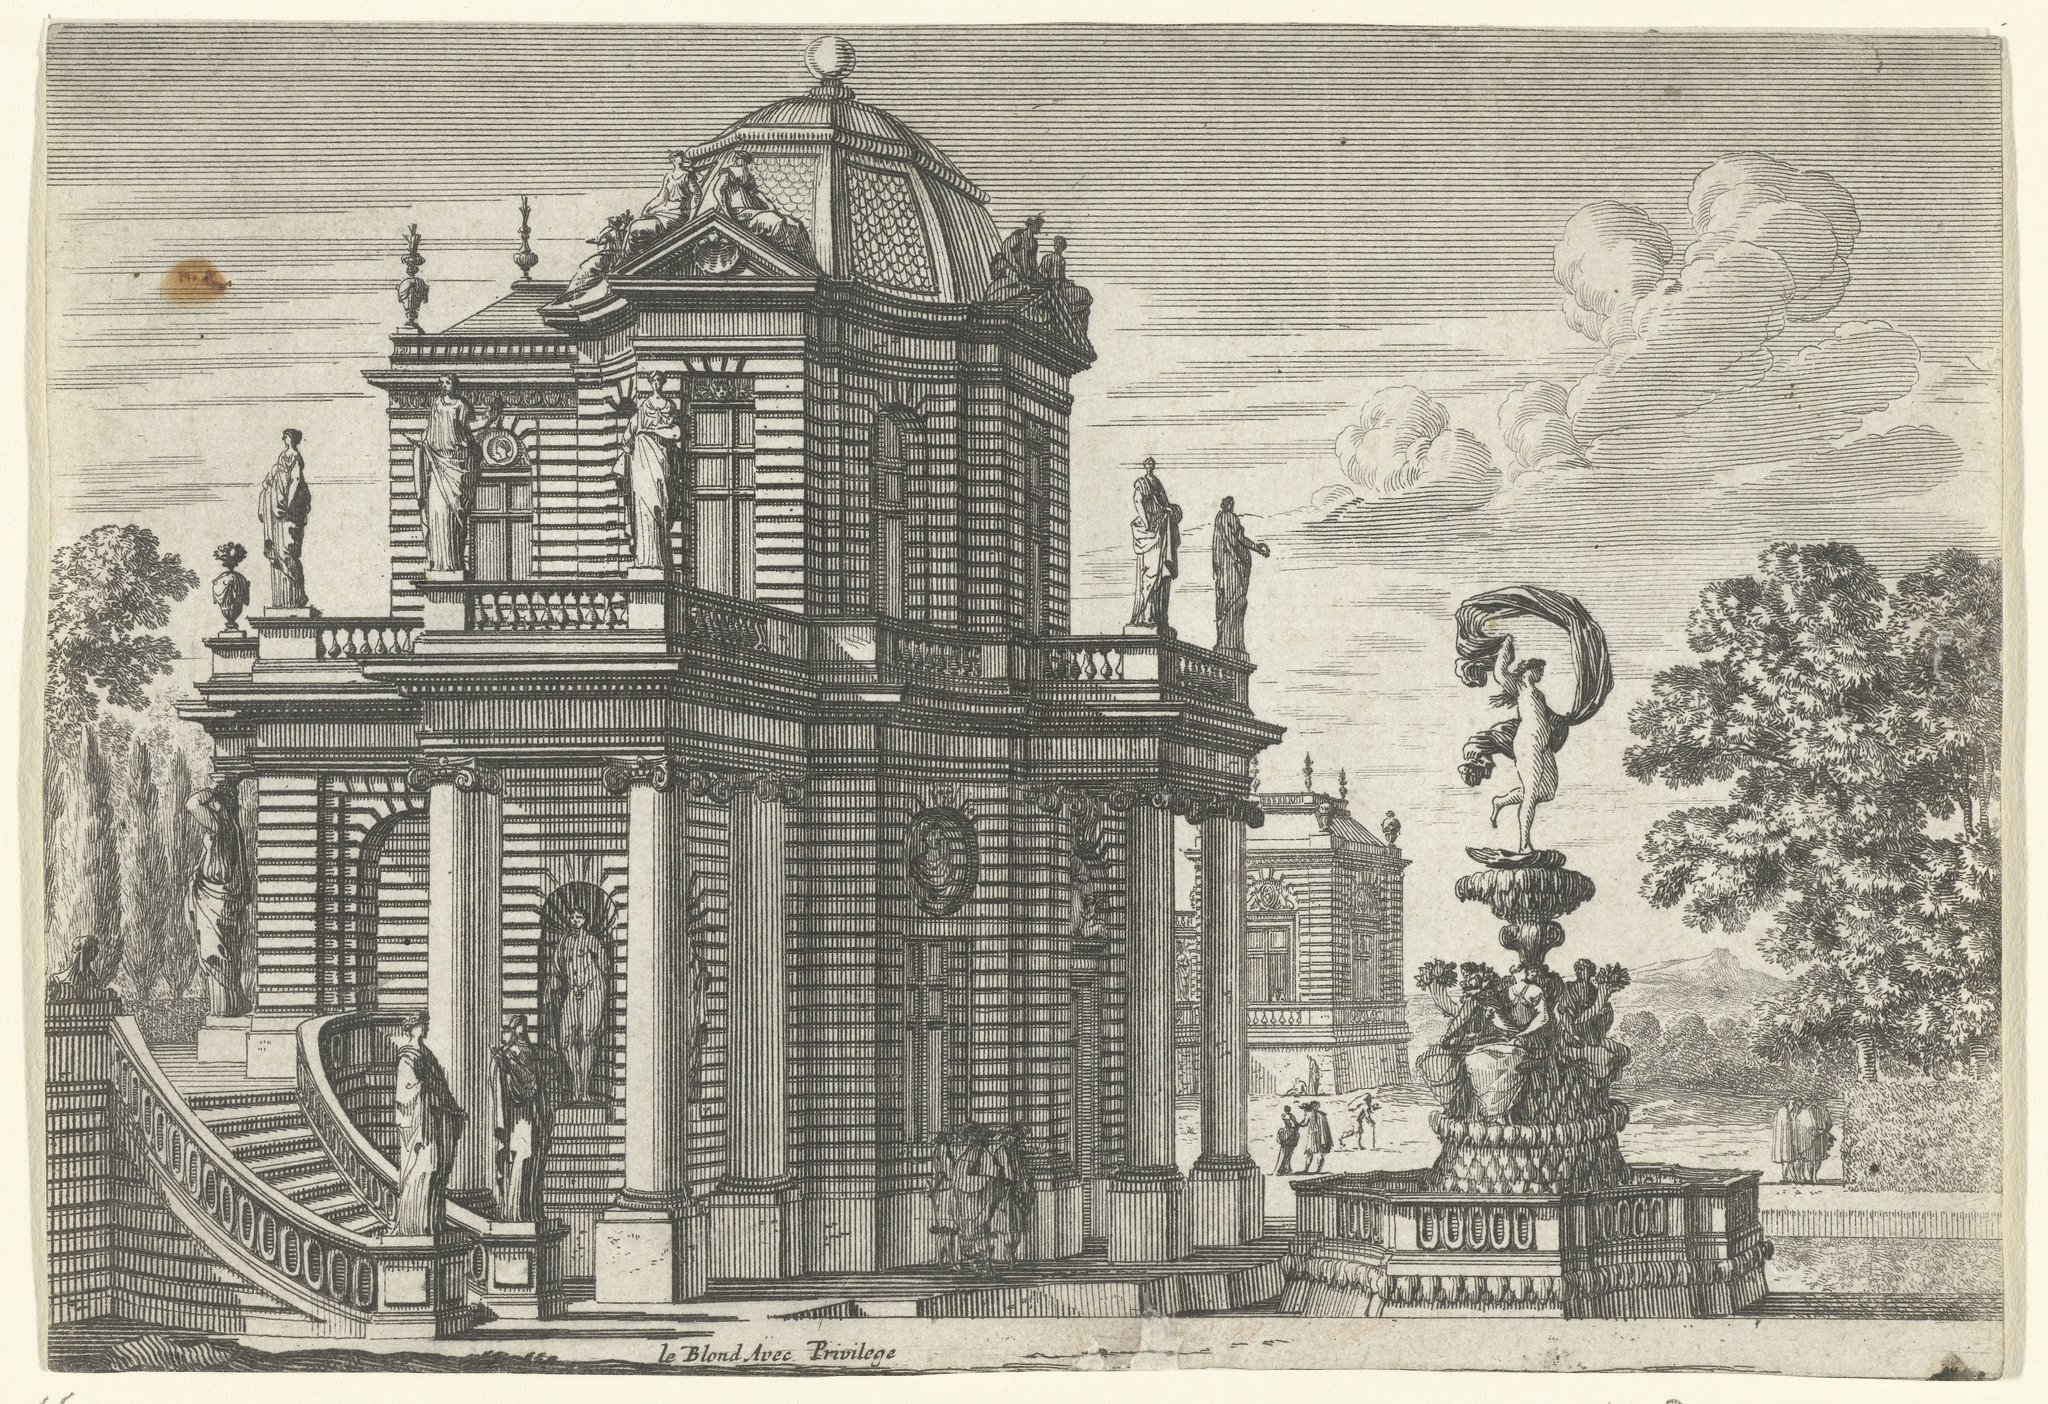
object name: print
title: Tuinpaviljoenen, grotten en fonteinen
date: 1650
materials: paper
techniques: etching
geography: france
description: Links een tuinpaviljoen met Ionische zuilen, rechts een fontein met Fortuna. Uit serie van 12 bladen.